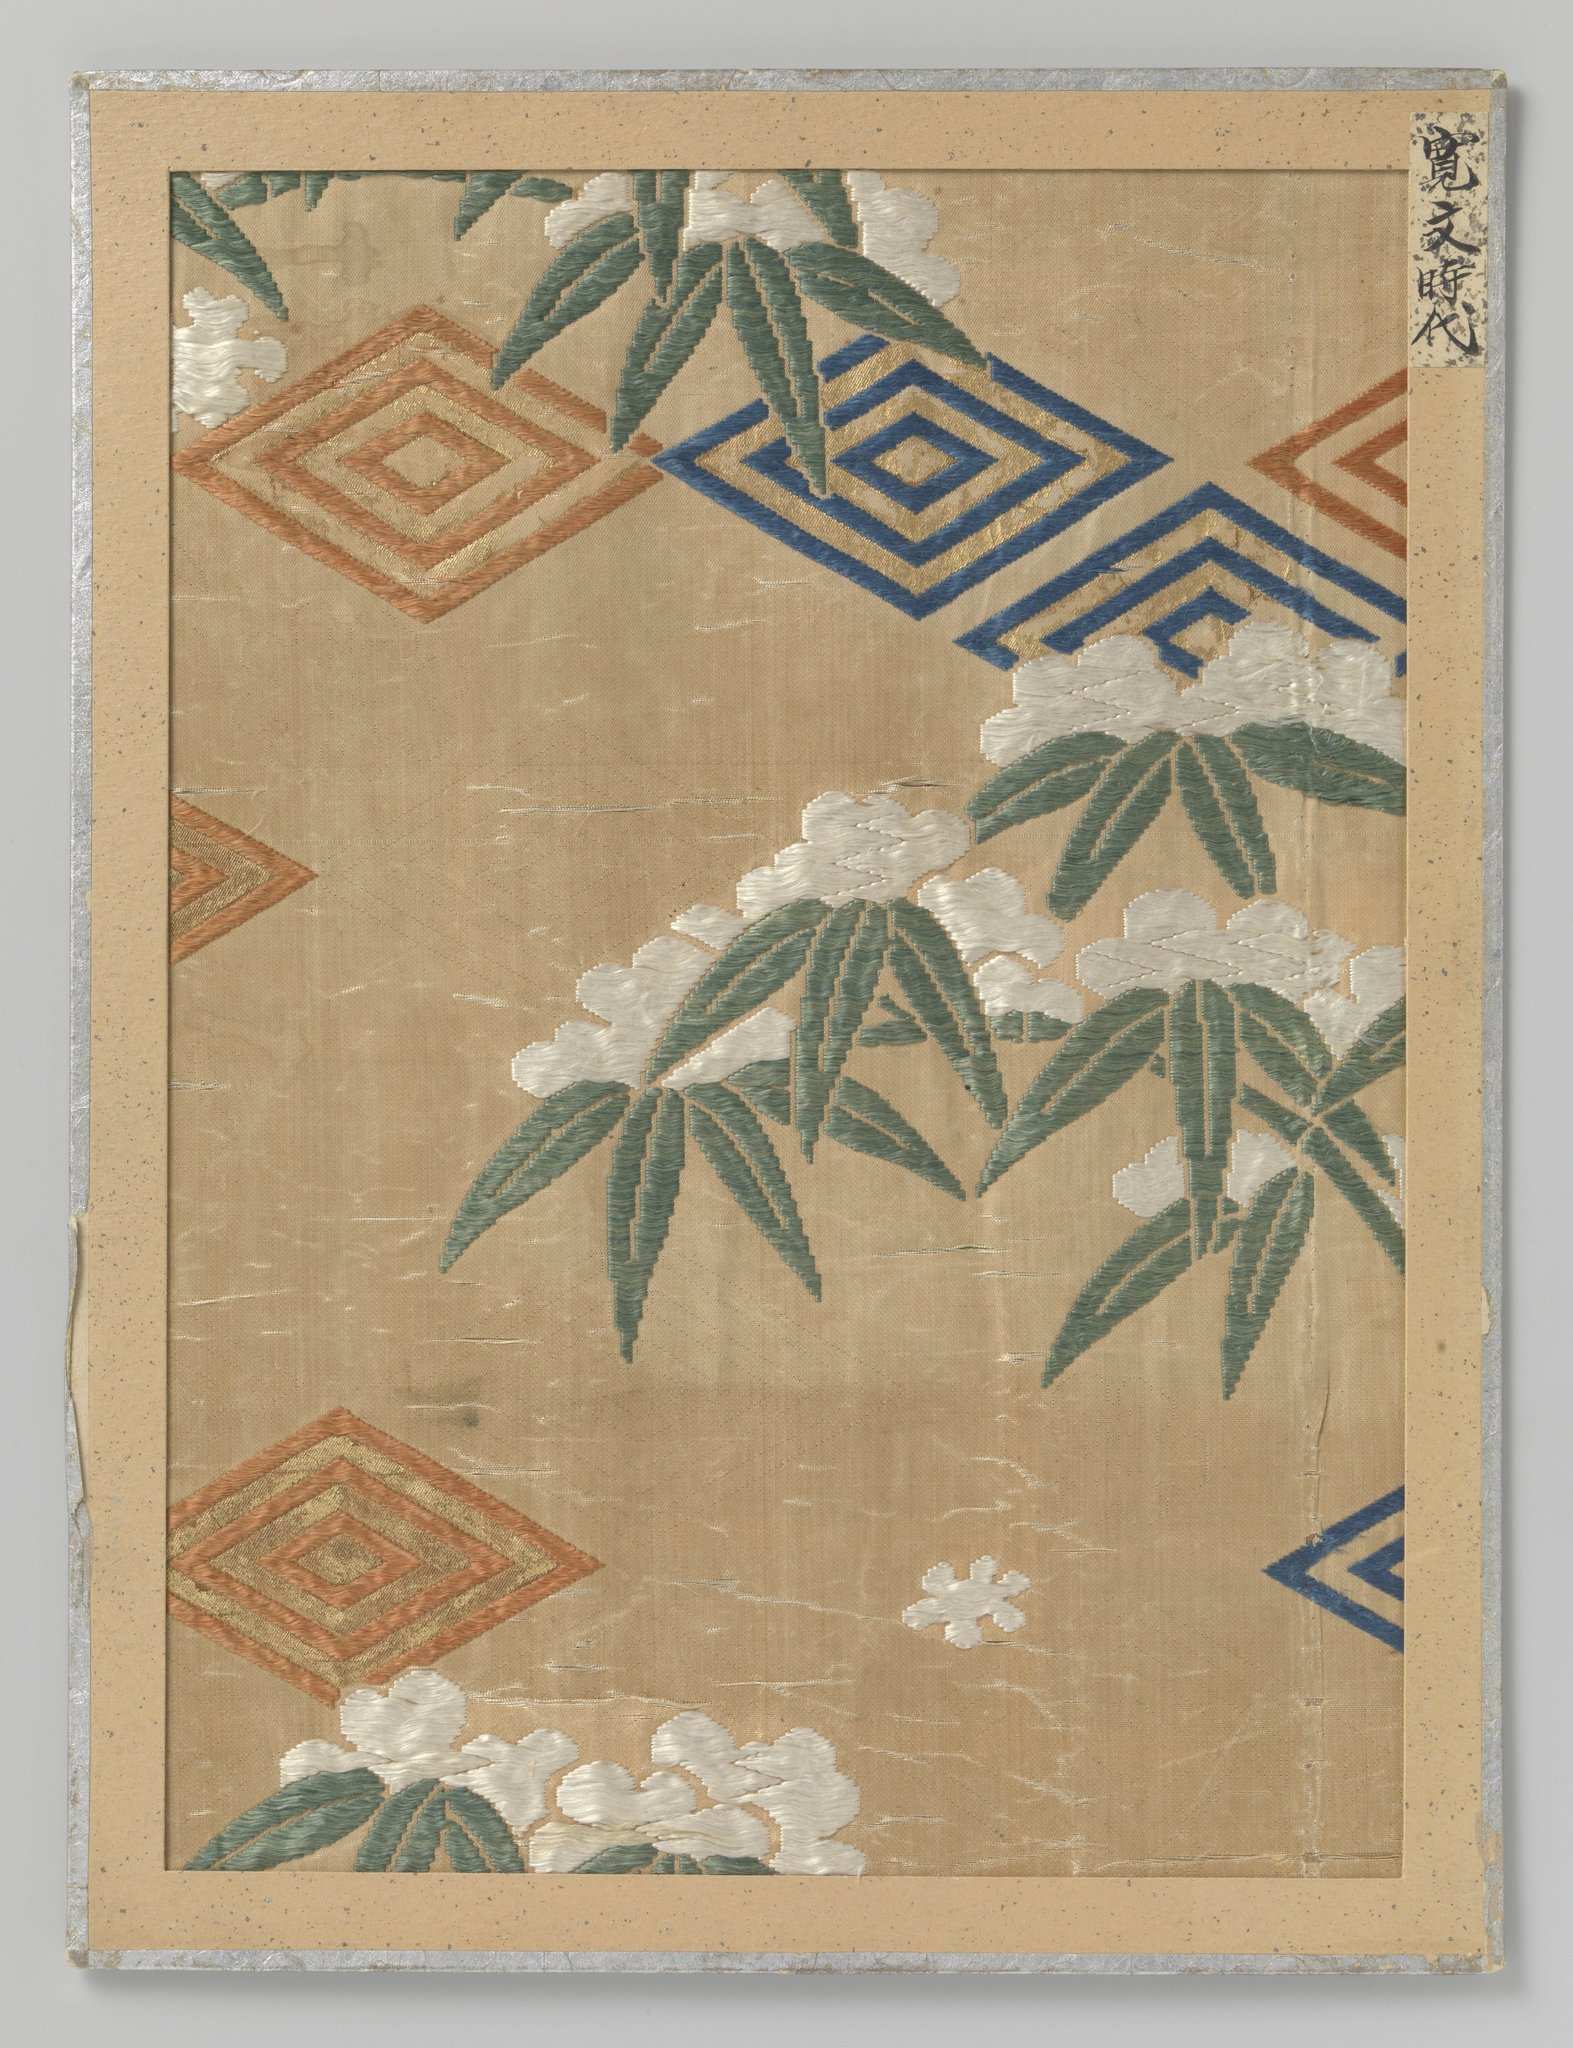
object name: fragment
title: Fragment textiel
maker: Anonymous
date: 1661-1673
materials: silk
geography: japan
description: Textielfragment, borduursel van witte oleanders en ruiten-motieven op okerkleurige zijde.